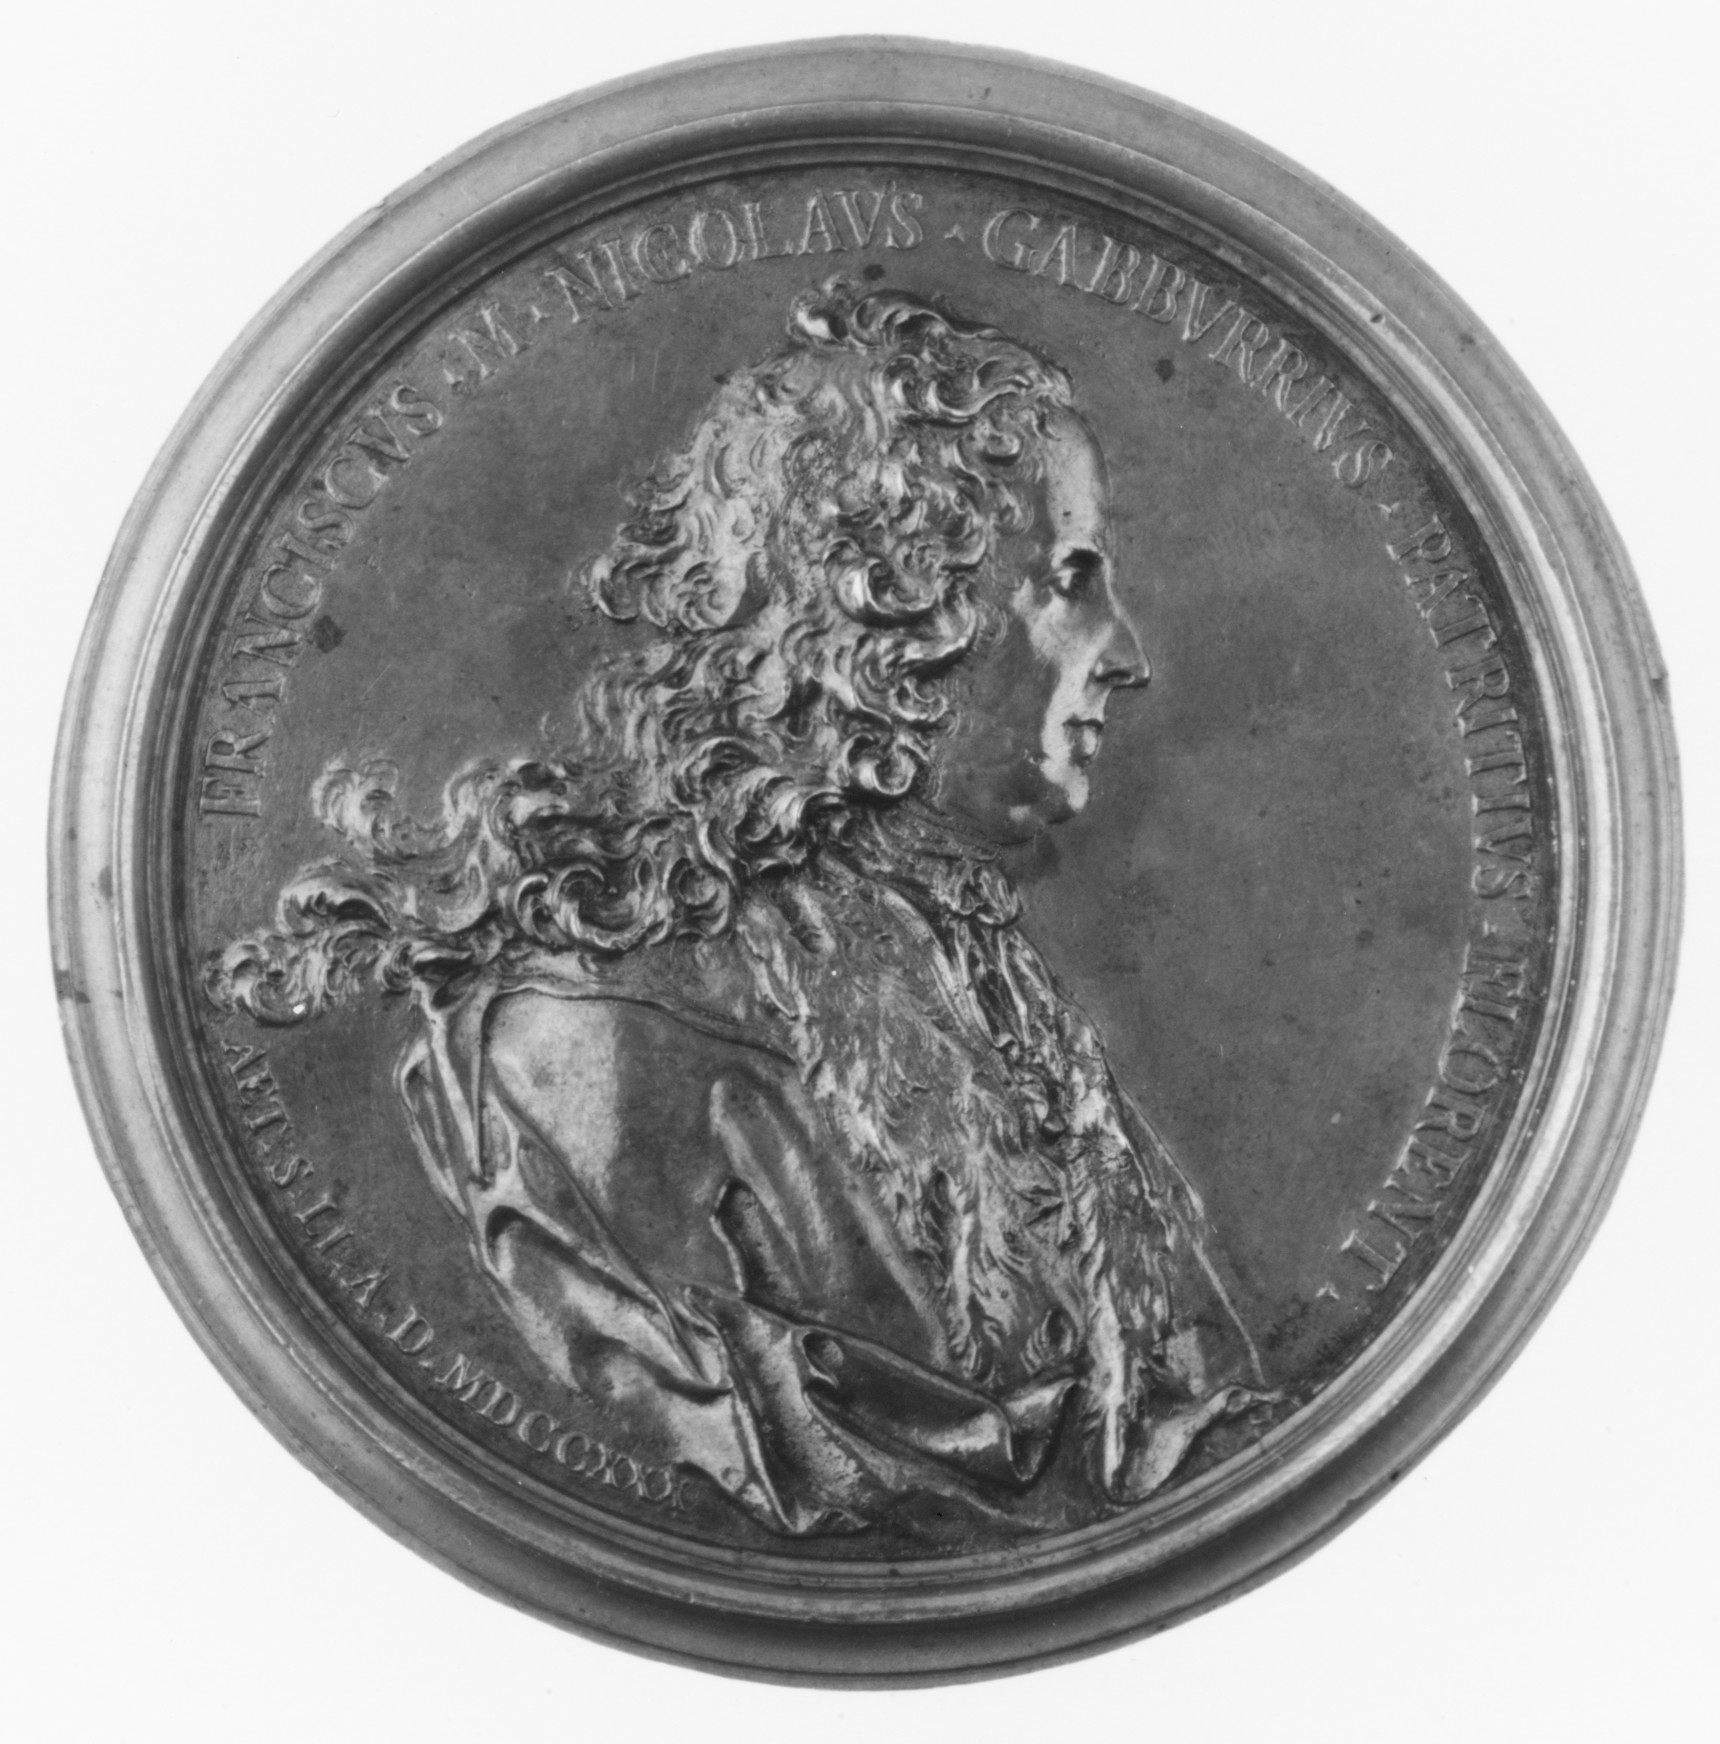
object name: medal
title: Francesco Niccolò Gabburri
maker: lorenzo maria weber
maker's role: artist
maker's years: 1692-1764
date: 1730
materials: bronze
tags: men,profiles